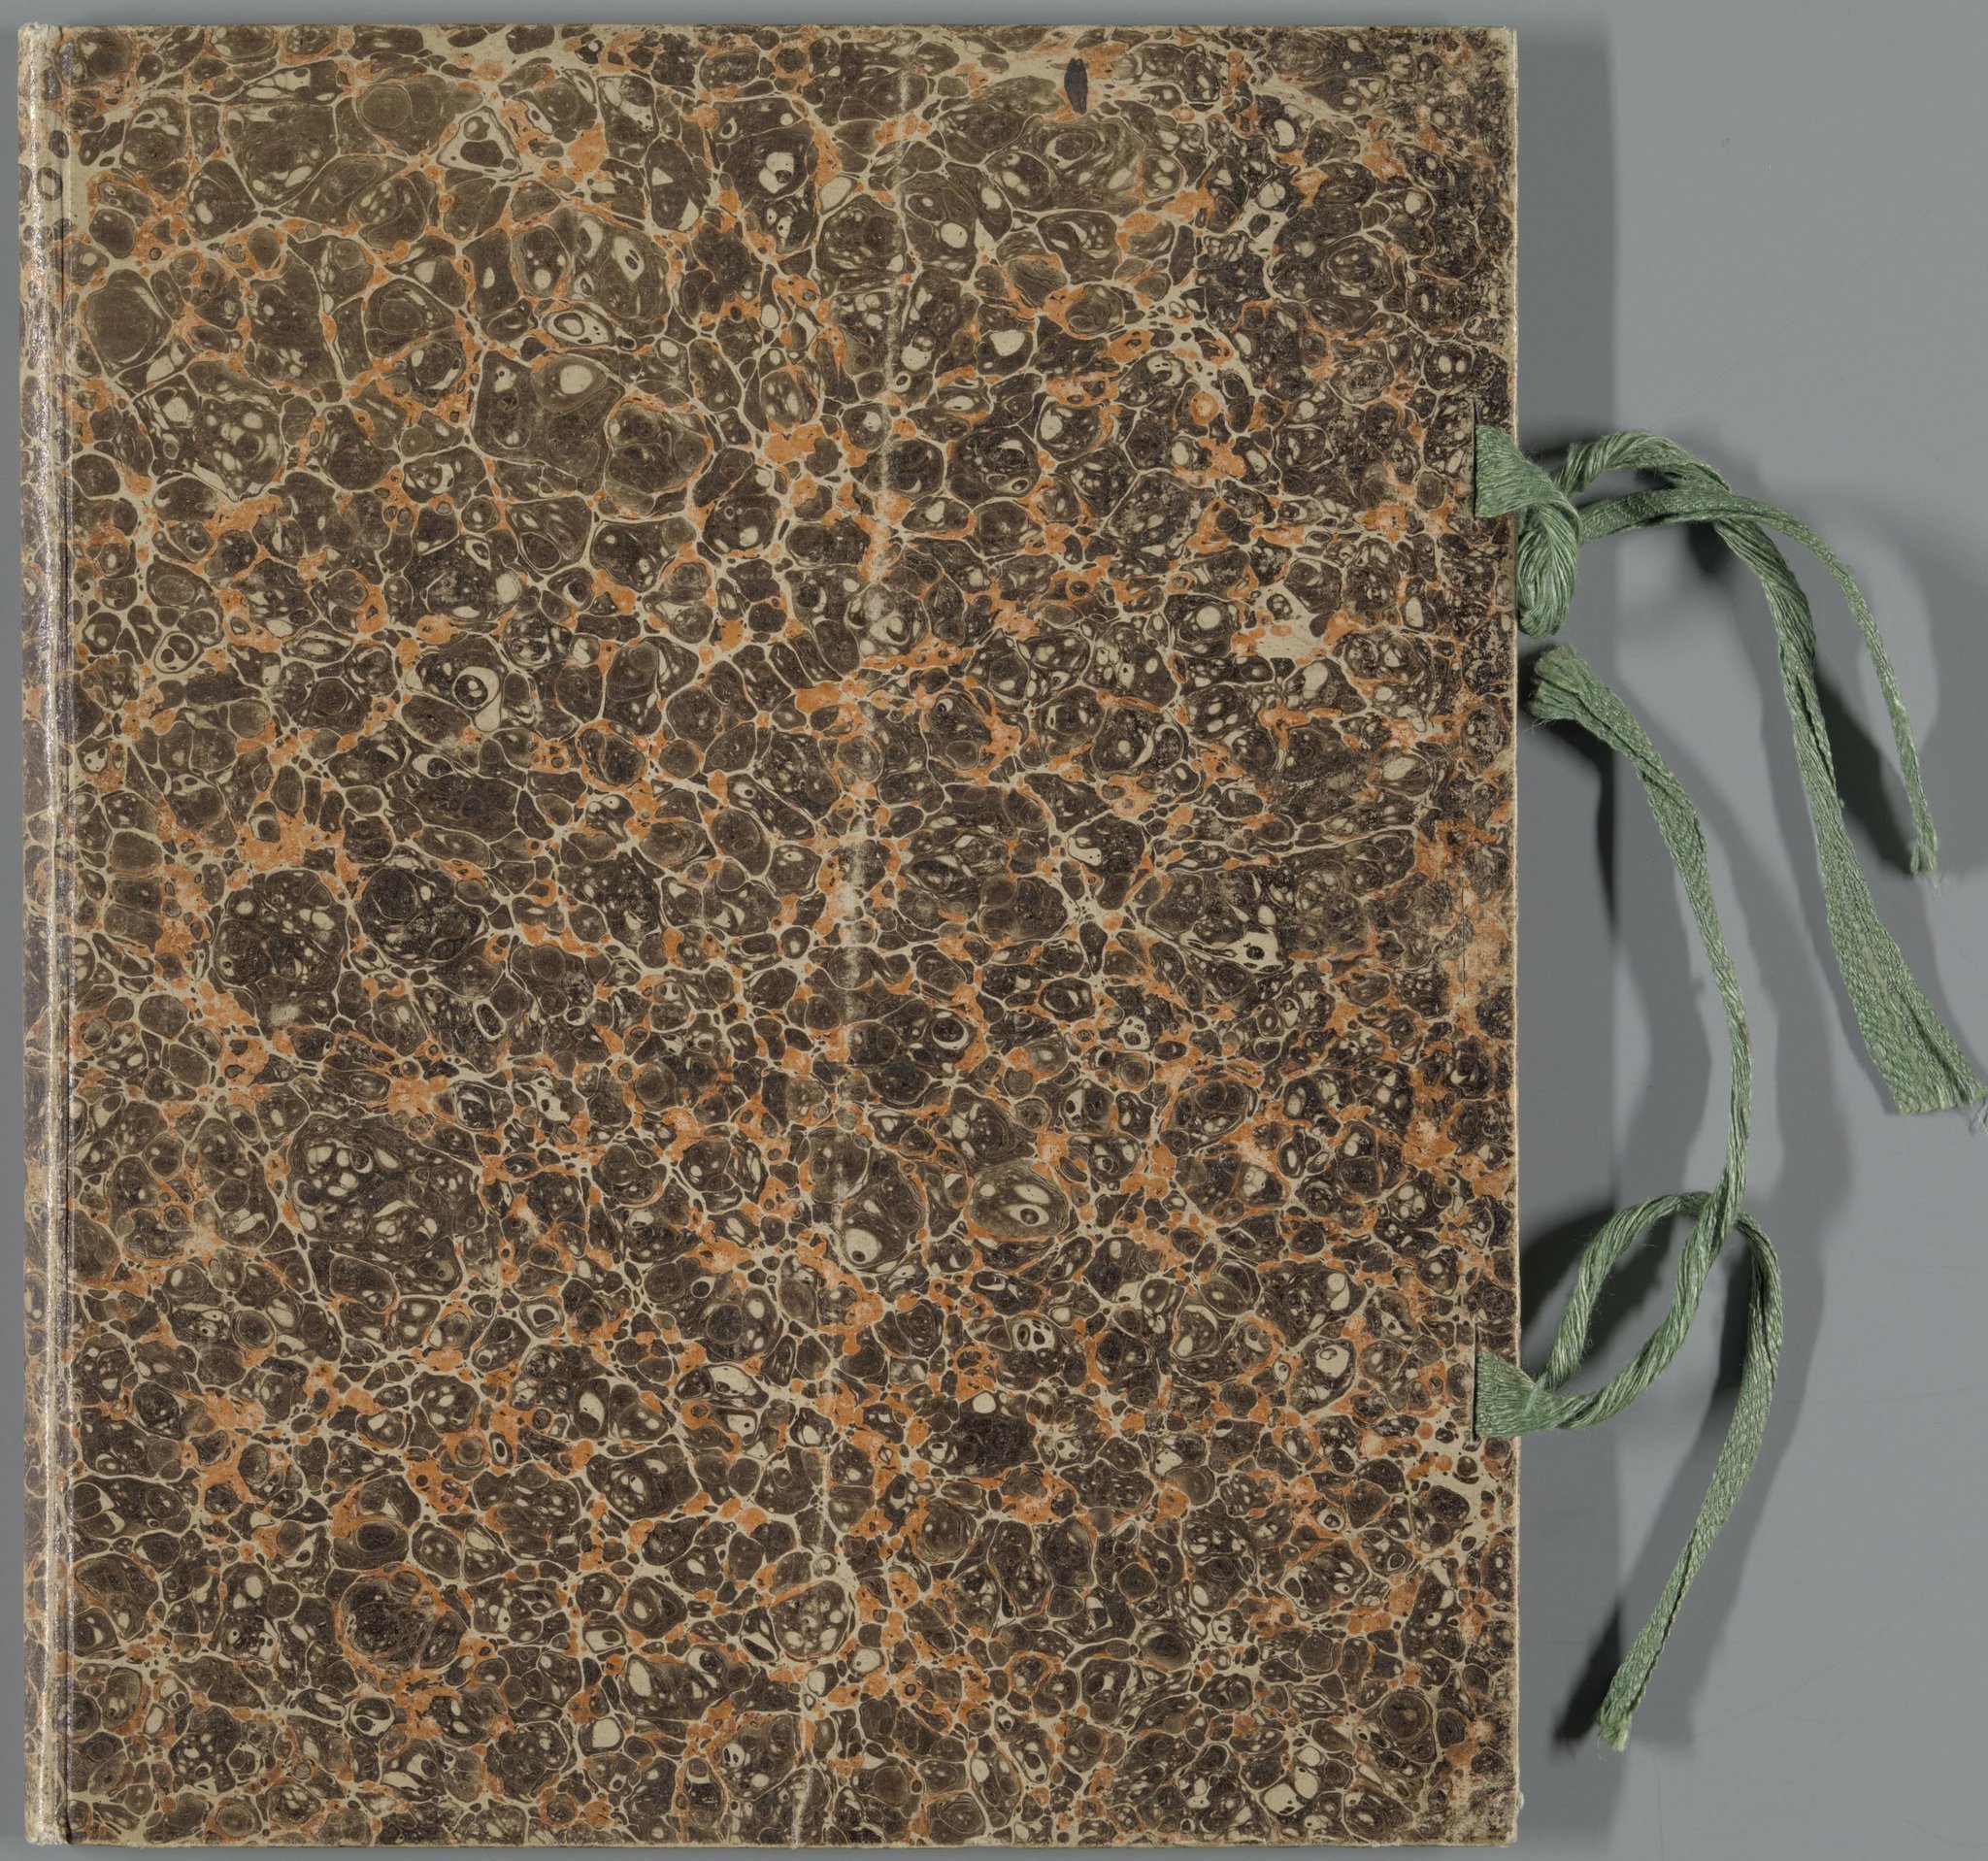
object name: sketchbook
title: Album met 17 betekende bladen met juwelen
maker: carl friedrich bärthel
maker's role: draughtsman, jeweler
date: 1800-1810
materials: cardboard, ink, paper, textile, watercolor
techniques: brush, pen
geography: augsburg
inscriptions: signature: ‘Carl Friedrich Bärthel’, watermark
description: Band van karton beplakt met gemarmerd papier met daarin bladen van licht blauw getint papier.